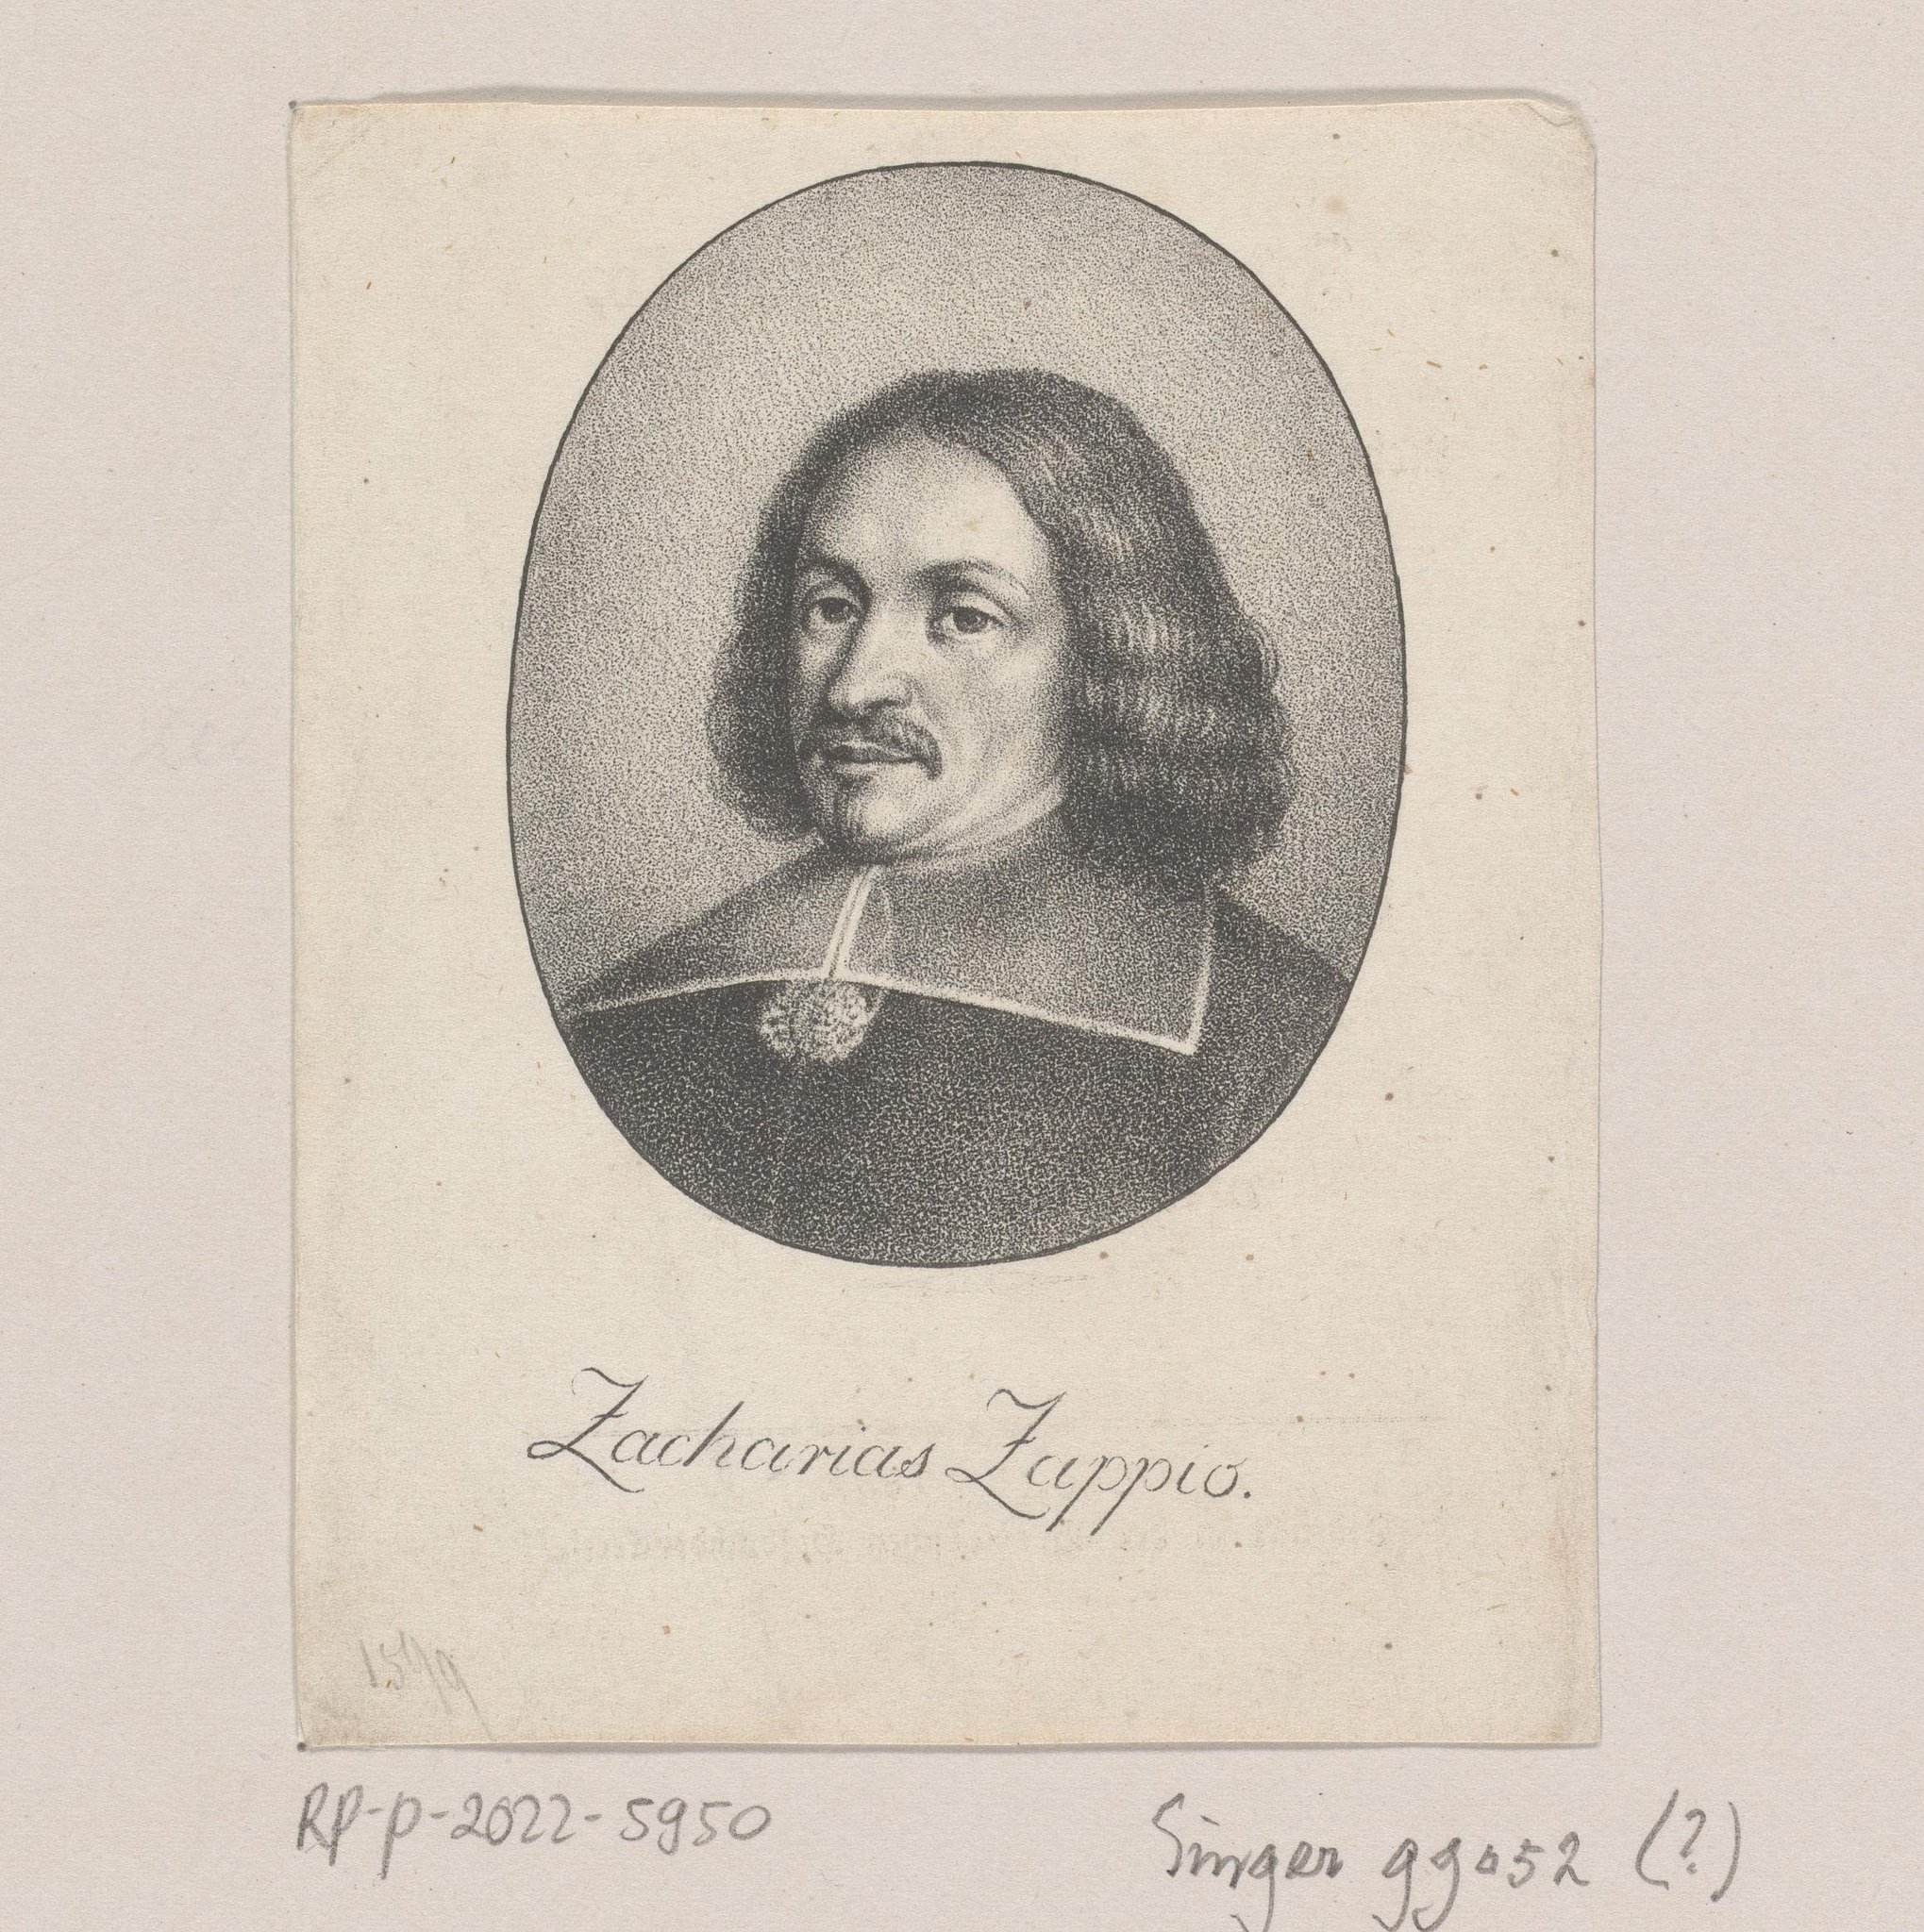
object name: print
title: Portret van Zacharias Zappio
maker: Anonymous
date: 1798-1850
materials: paper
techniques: engraving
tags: historical persons, merchant, salesman